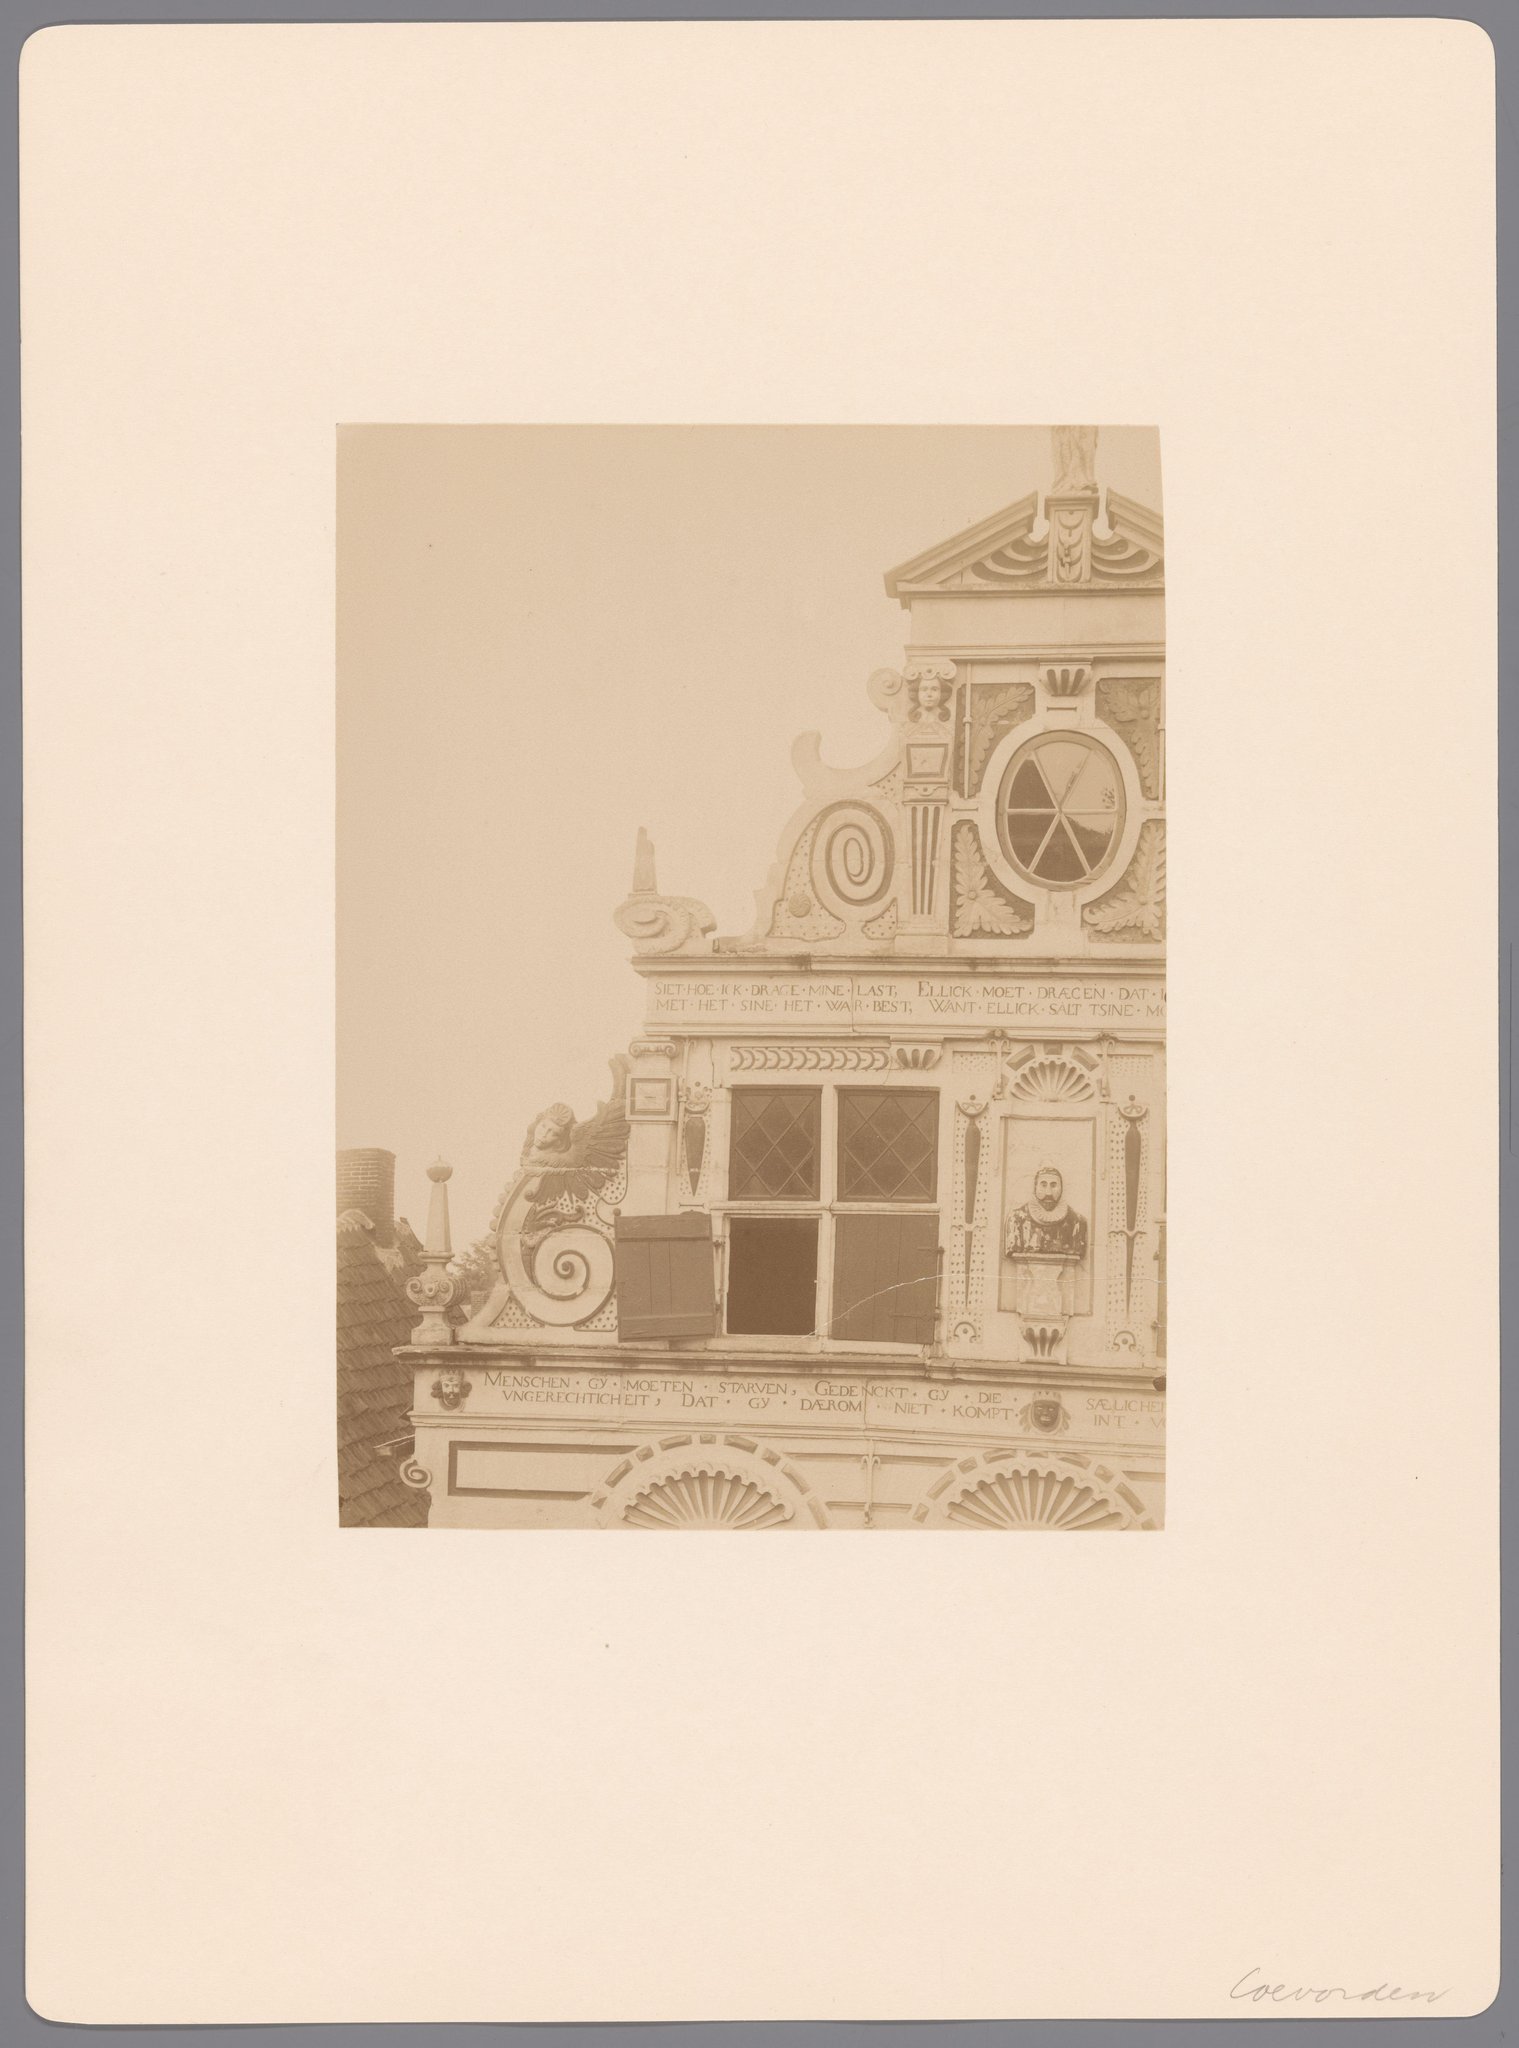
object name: photograph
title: Gevel van Friesestraat 9 te Coevorden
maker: anoniem (monumentenzorg)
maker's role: fotograaf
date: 1890-1910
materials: cardboard, photographic support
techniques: albumen print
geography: coevorden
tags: façade (of house or building)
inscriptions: annotation: ‘18’, annotation: ‘Coevorden’